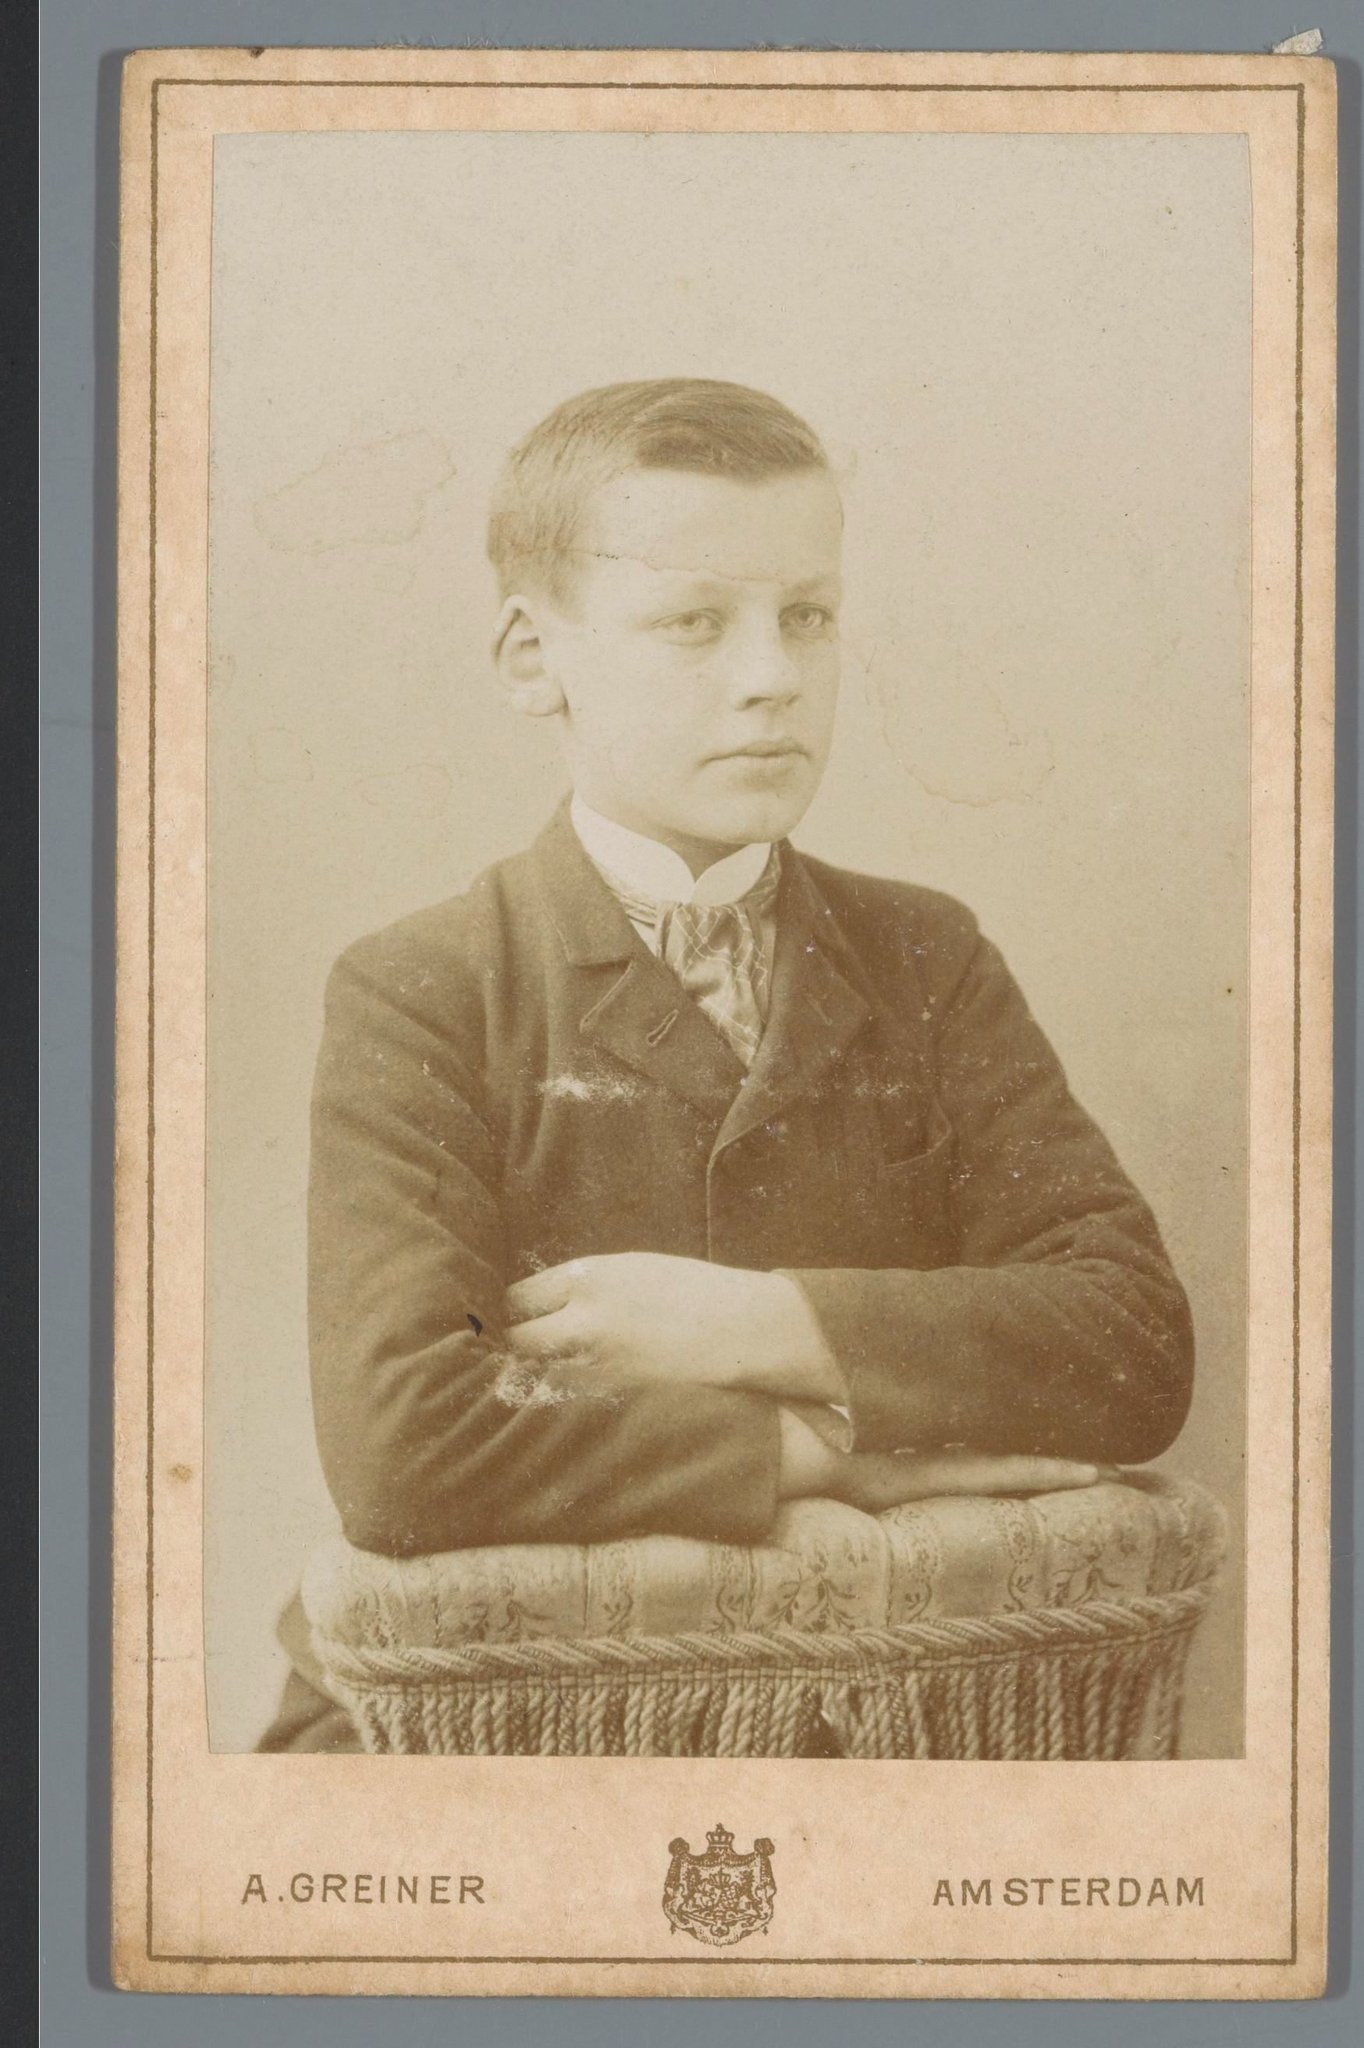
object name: photograph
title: Portret van een onbekende jongen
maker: albert greiner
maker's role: fotograaf, fotostudio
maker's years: 1833-1890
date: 1874-1887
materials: cardboard, photographic support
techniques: collodion silver print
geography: amsterdam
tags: boy (child between toddler and youth), historical persons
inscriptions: inscription: ‘ALBERT GREINER/ Photograaf van wijlen Z.M. den/ Koning Willem III en H.M. de Koningin Weduwe/ AMSTERDAM/ NIEUWENDIJK 89./ Specialiteit in Vergrootingen.’